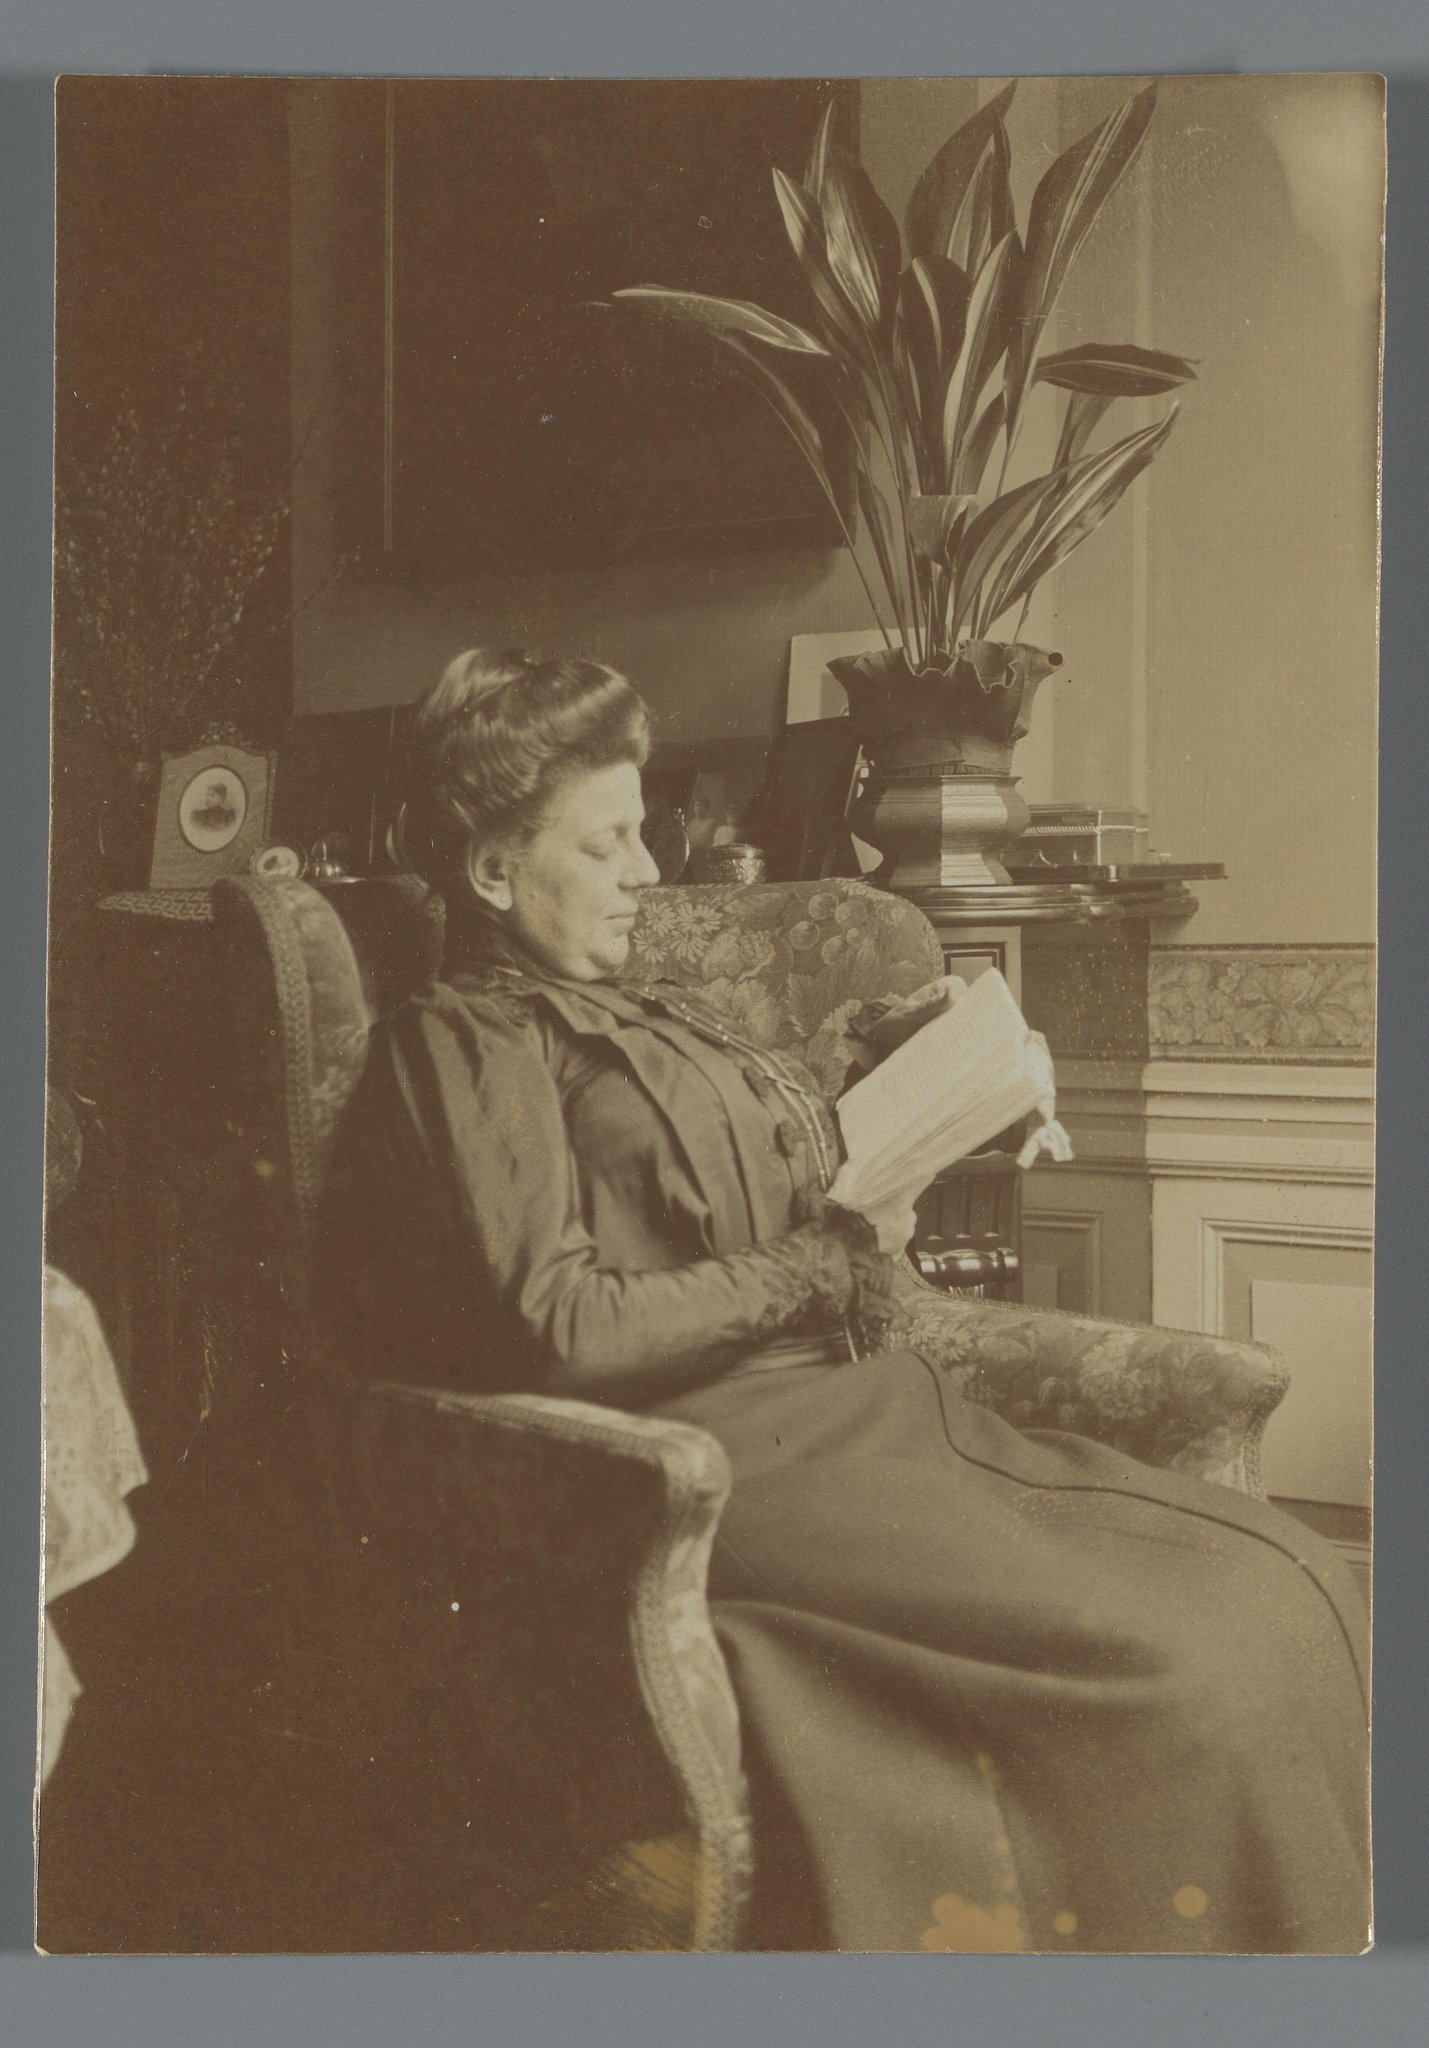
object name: photograph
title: Pauline van den Berg lezend in een fauteuil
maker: Anonymous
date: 1895-1910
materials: photographic support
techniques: albumen print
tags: batavia, the hague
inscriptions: inscription: ‘tante Pau’